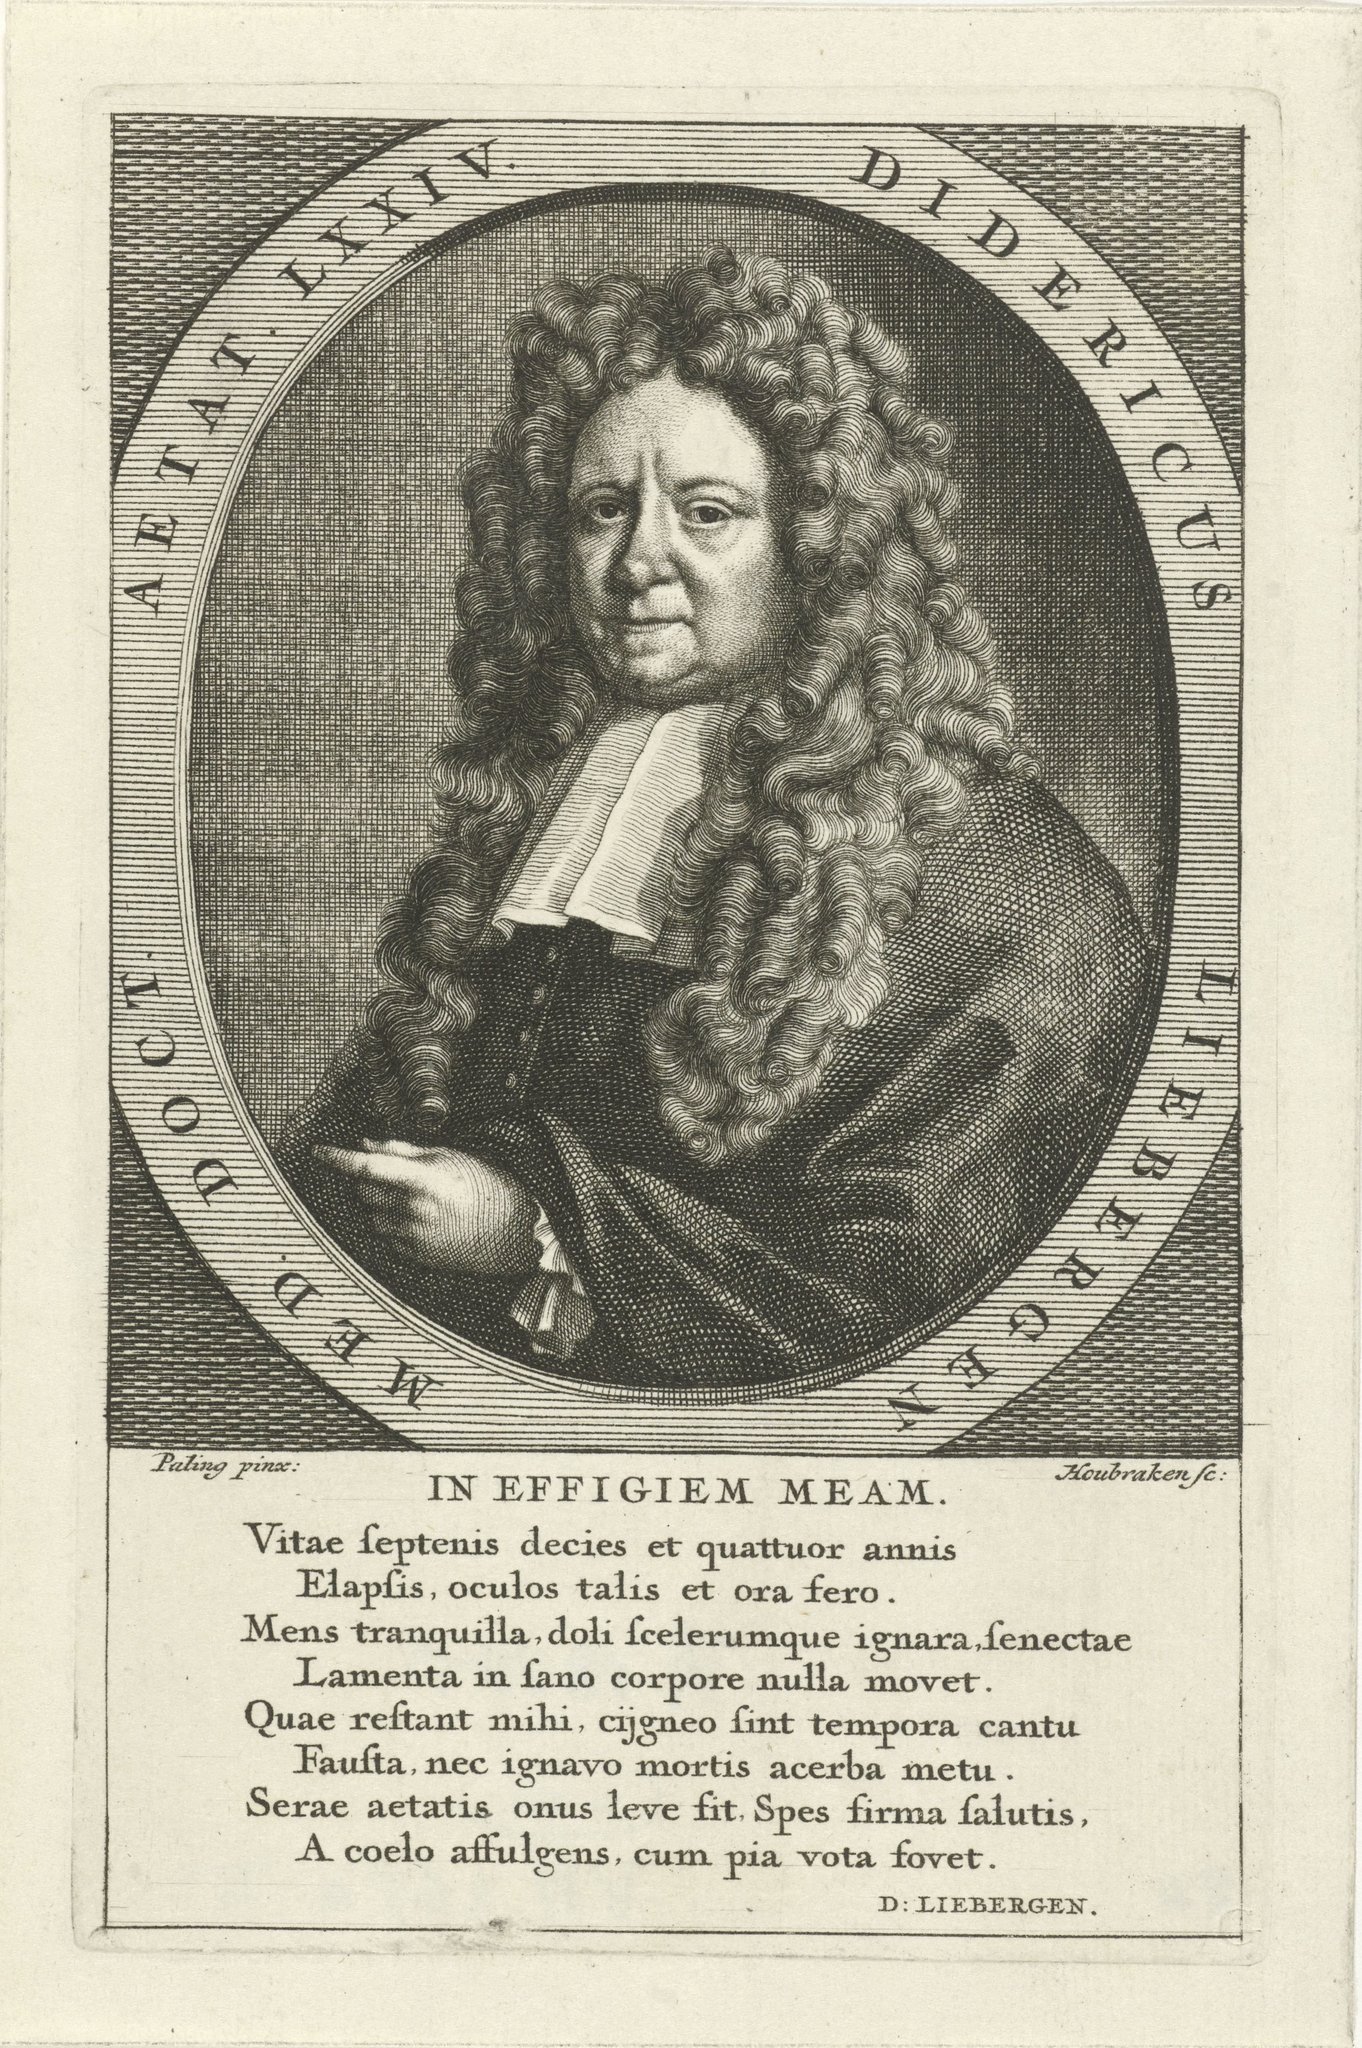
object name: print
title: Portret van Didericus Liebergen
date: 1708-1780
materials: paper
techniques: engraving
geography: amsterdam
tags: didericus liebergen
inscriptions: collector's mark: Lugt 2228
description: Portret naar links van Didericus Liebergen op 74-arige leeftijd in een ovaal met randschrift in het Latijn. Onder het portret negen regels in het Latijn.